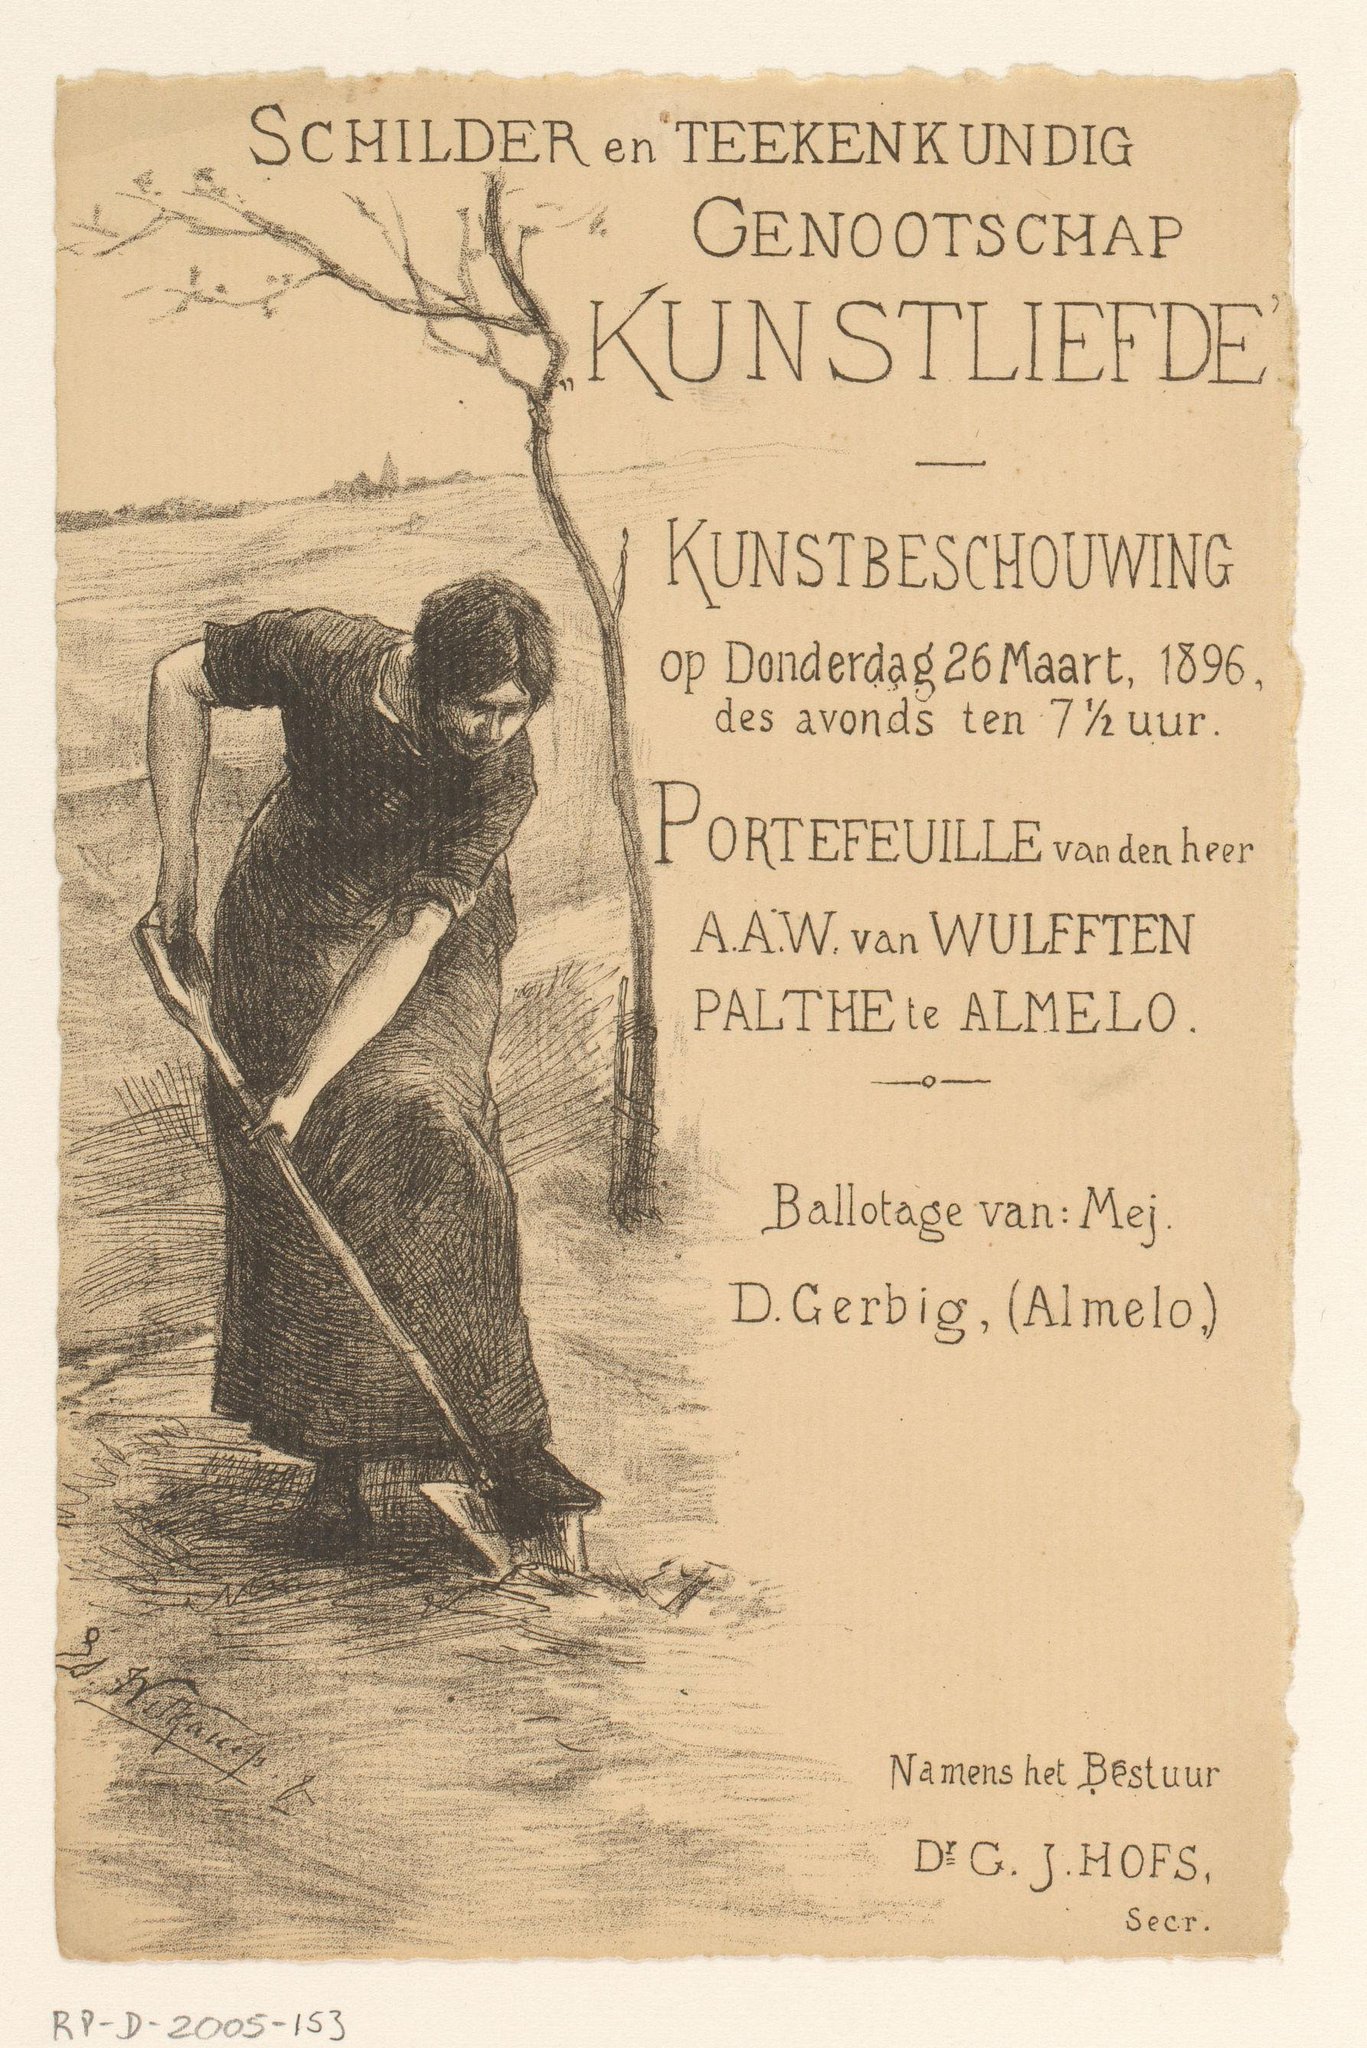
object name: print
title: Uitnodiging van Schilder- en Teekenkundig Genootschap "Kunstliefde" voor een kunstbeschouwing, 26 maart 1896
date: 1803-1896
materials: paper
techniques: lithograph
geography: utrecht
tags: criticizing and discussing art, art criticism, circle, club of artists, collecting and exhibiting products of the fine arts, farmers - aa - female farmer, farmer's wife, spading ~ soil cultivation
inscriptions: collector's mark: Lugt 2228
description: Spittende boerin. Uitnodiging van Schilder- en Teekenkundig Genootschap "Kunstliefde" voor een kunstbeschouwing op 26 maart 1896 van de portefeuille van de dhr. A.A.W. van Wulfften en dhr. Palthe te Almelo.